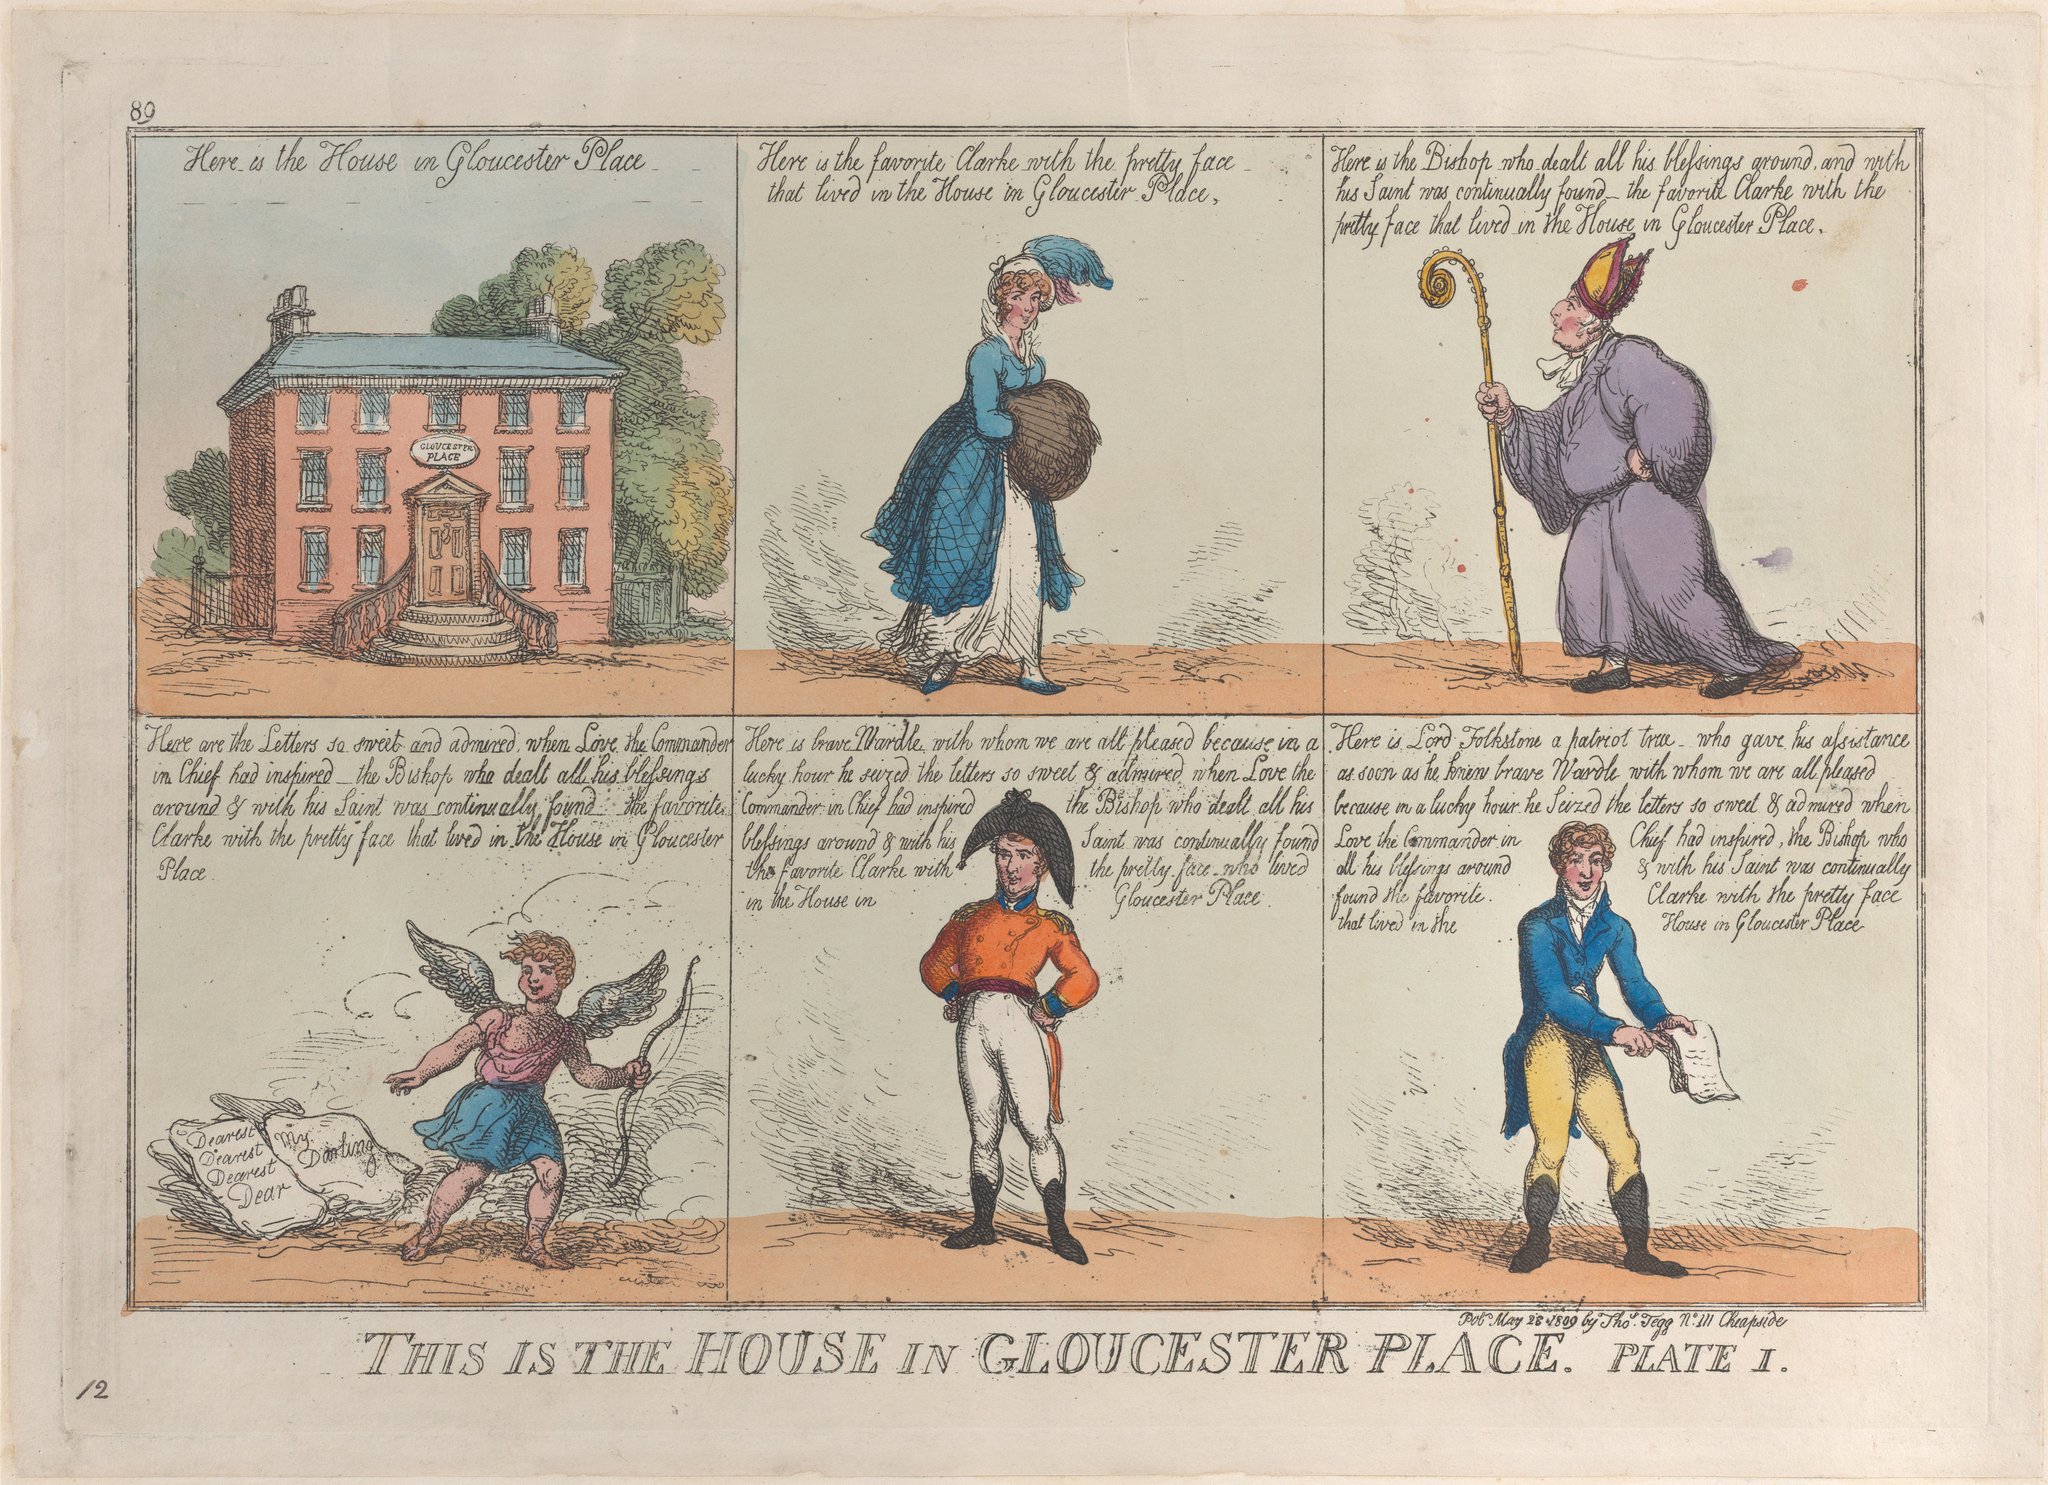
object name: print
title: This is the House in Gloucester Place, Plate 1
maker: thomas rowlandson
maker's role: artist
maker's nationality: british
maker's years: 1757-1827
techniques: etching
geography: london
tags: satire,men,women,bishops,politics